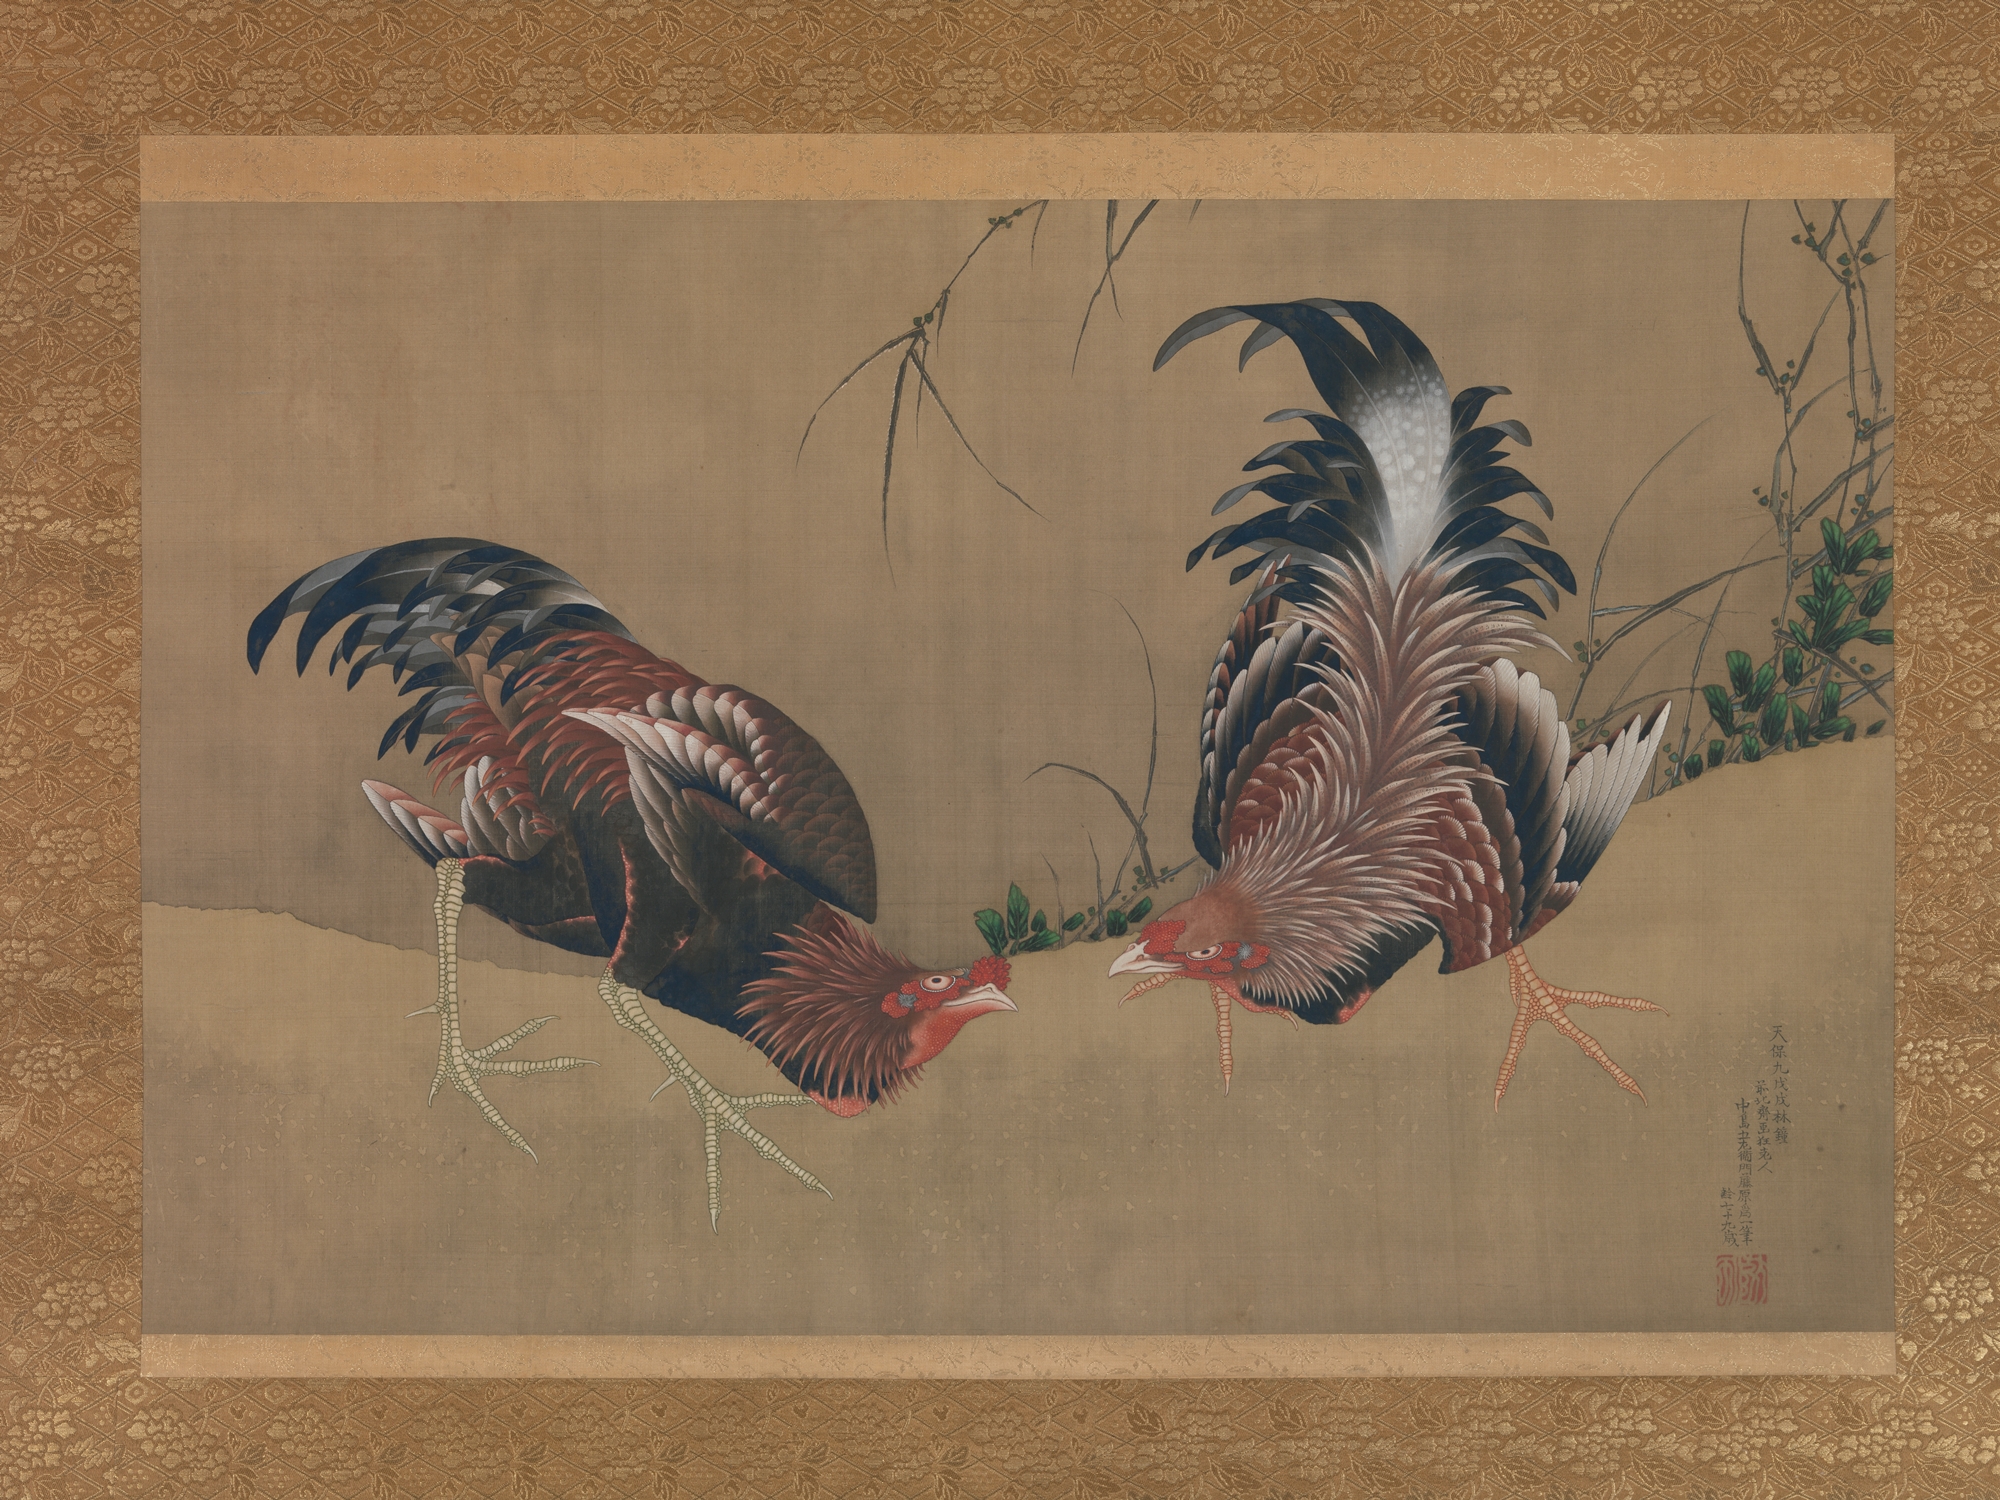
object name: hanging scroll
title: Gamecocks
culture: japanese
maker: katsushika hokusai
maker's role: artist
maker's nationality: japanese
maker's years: 1760-1849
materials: ink, silk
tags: roosters